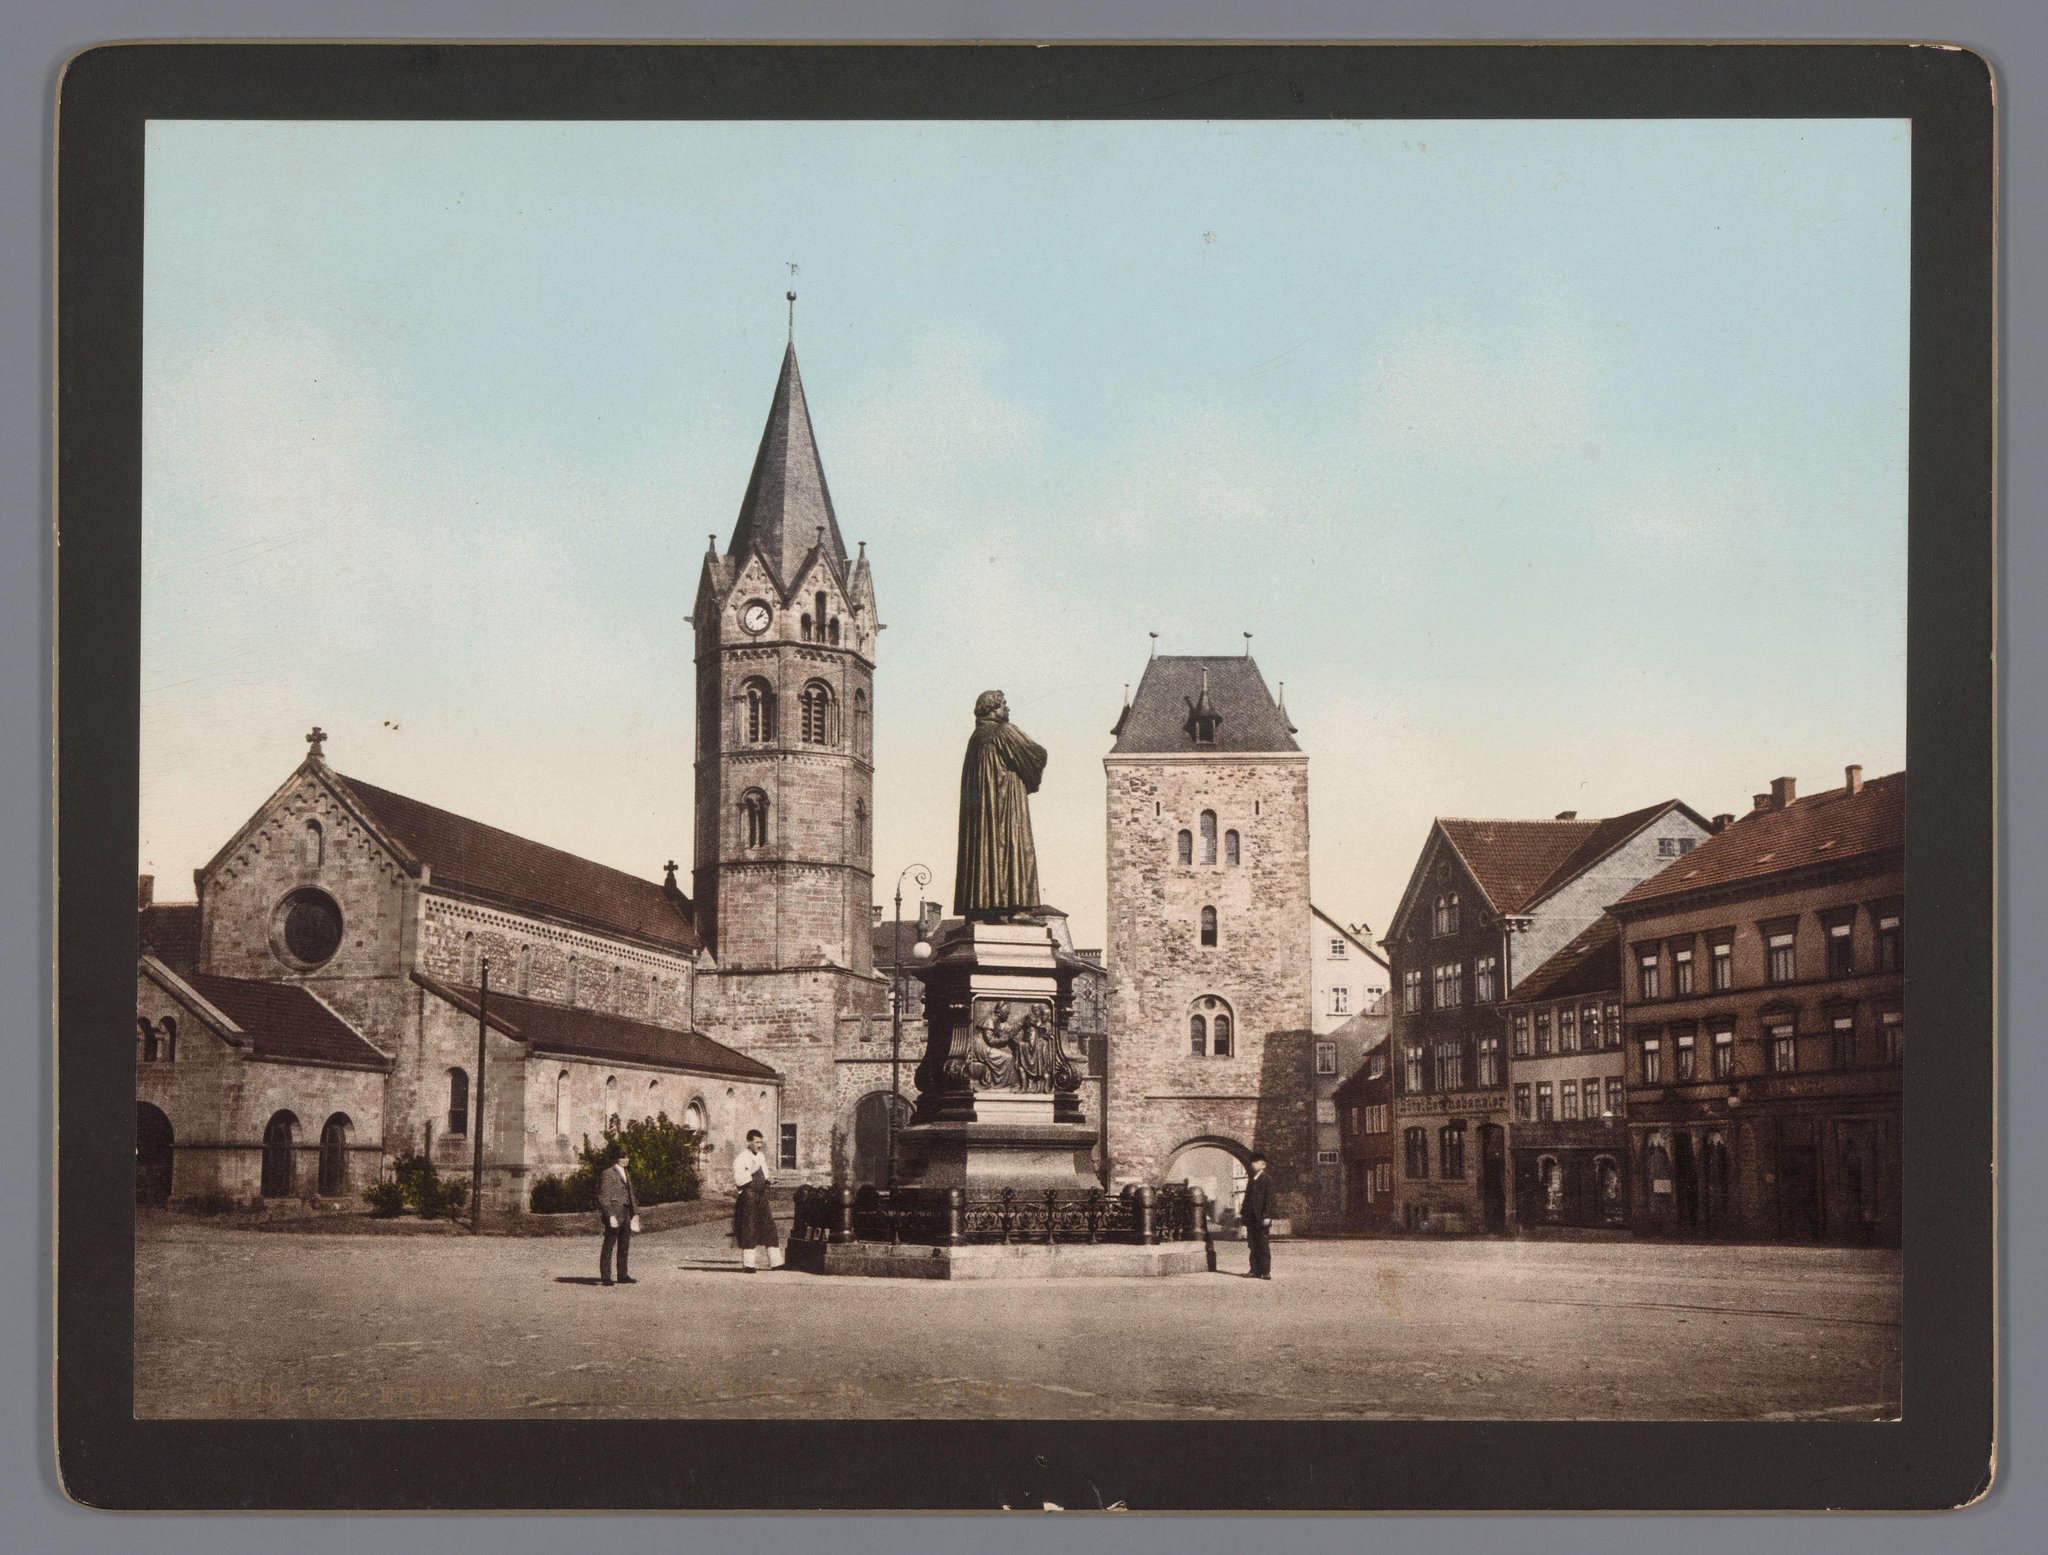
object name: photomechanical print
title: Gezicht op het Karlsplatz in Eisenach met het standbeeld van Martin Luther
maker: Anonymous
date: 1889-1920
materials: cardboard, paper, photographic process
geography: eisenach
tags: priest, martin luther, square, place, circus, etc., monument, statue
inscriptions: number: ‘6448.’